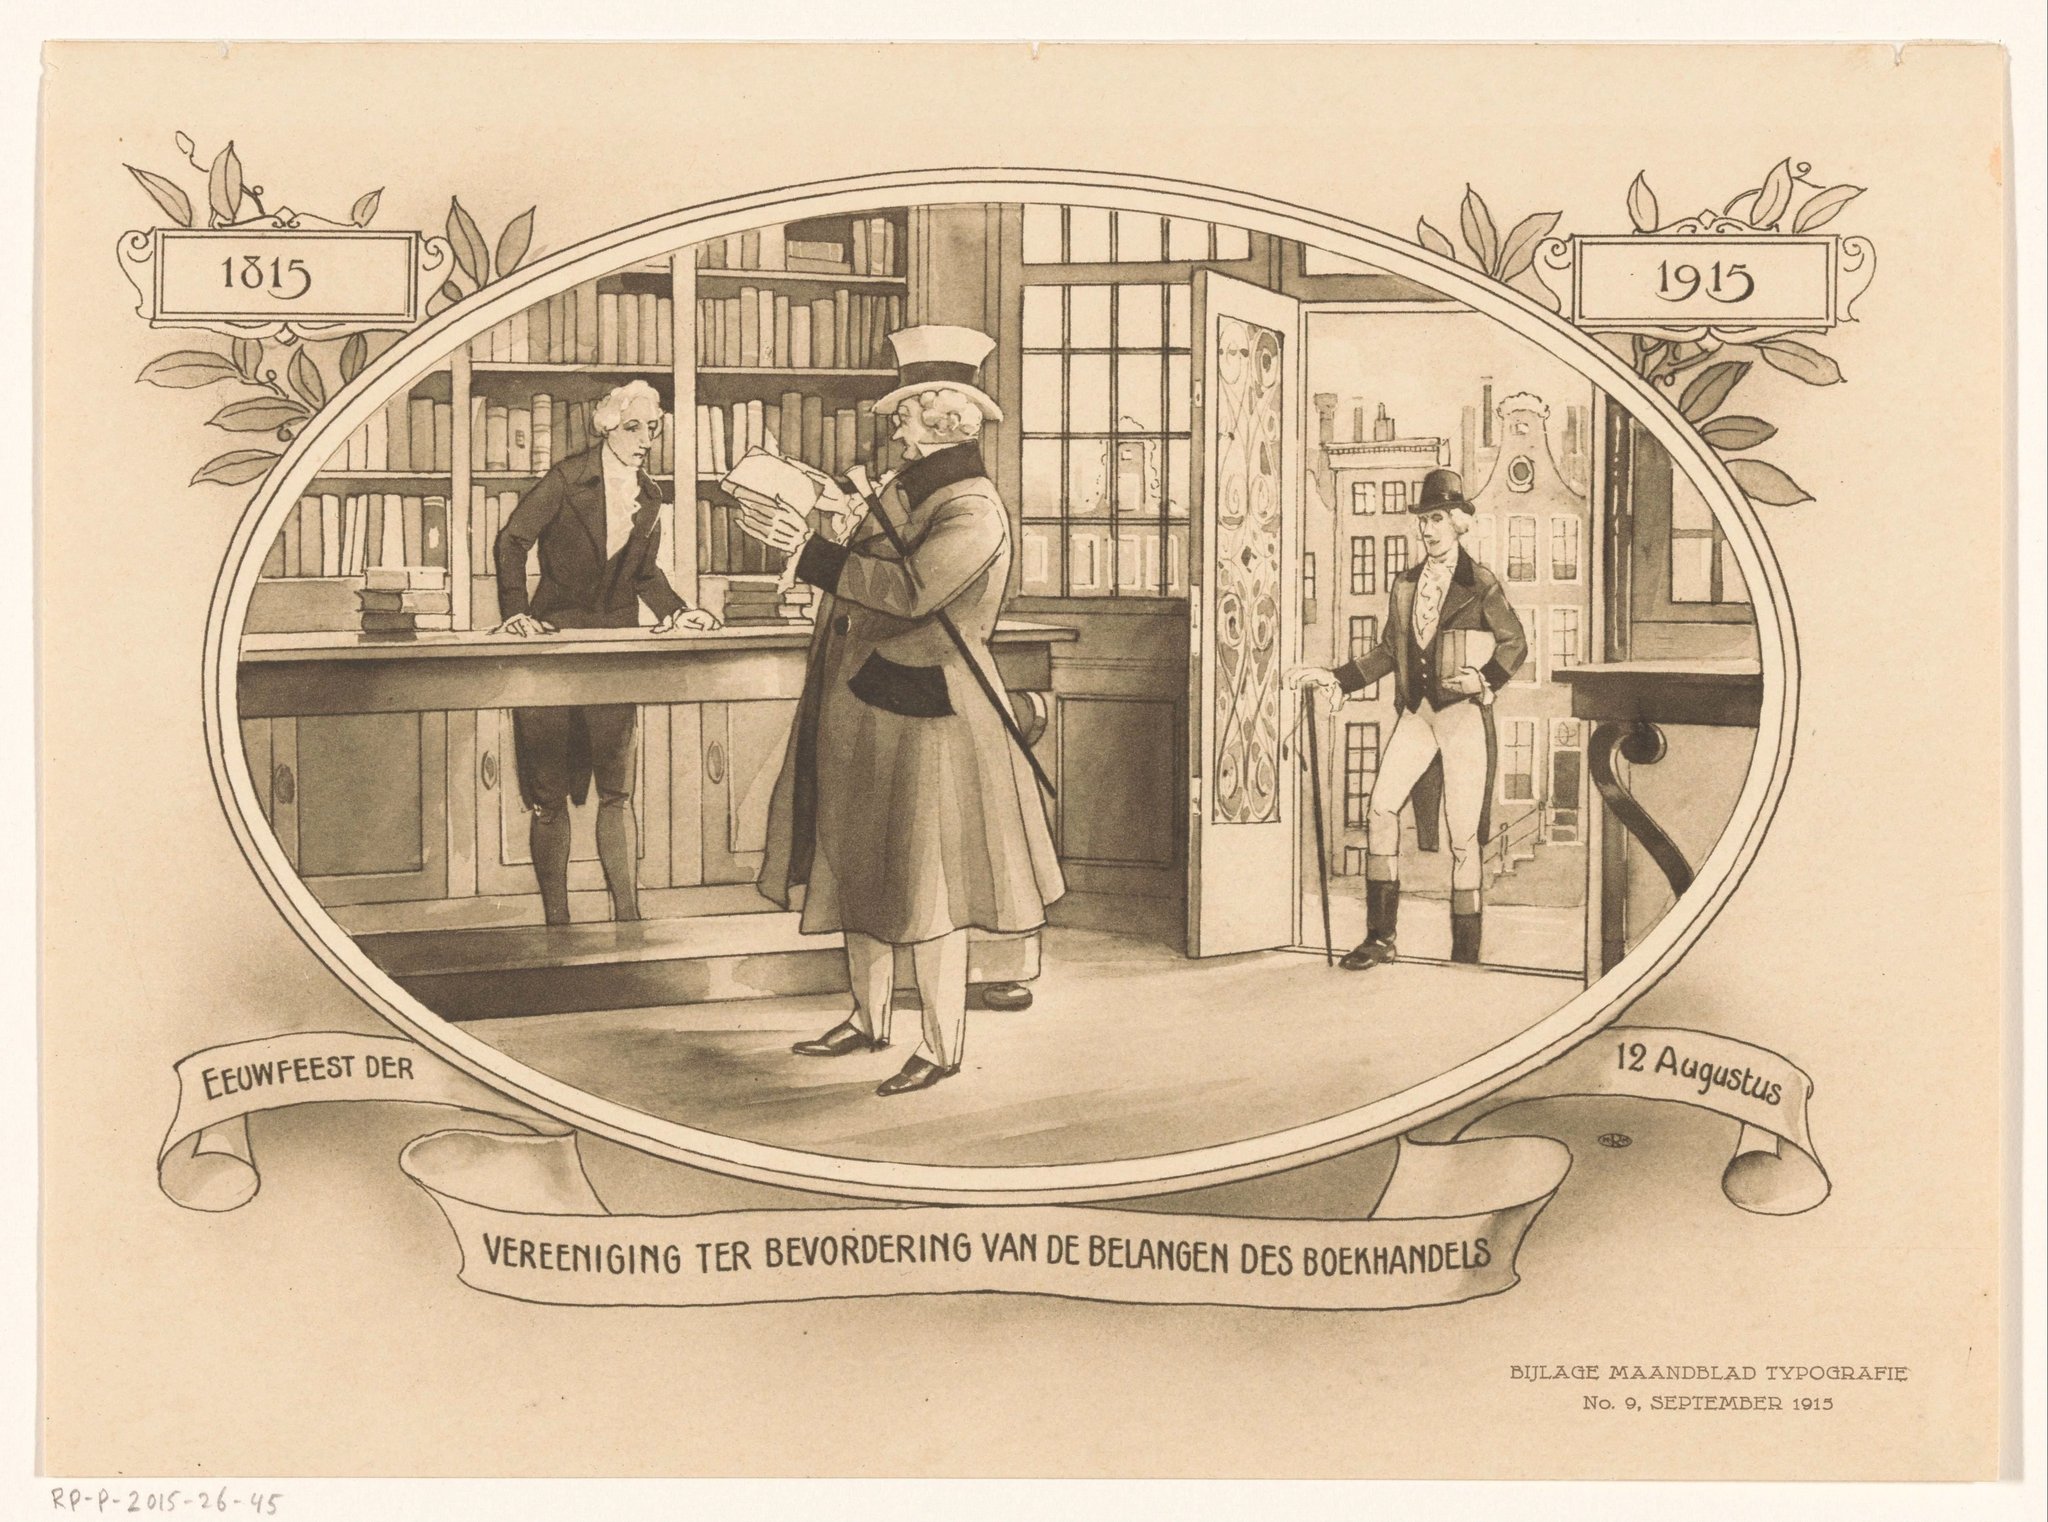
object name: print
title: Interieur van een boekhandel anno 1815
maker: Anonymous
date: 1915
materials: paper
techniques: rotogravure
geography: leiden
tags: book-shop, bookseller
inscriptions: collector's mark: Lugt 4780, collector's mark: Lugt 4779, collector's mark: Lugt 2228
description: Rechts onder met: Bijlage Maandblad Typografie No. 9, September 1915.